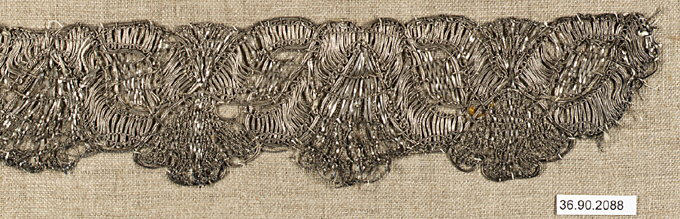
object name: piece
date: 1801-1900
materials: metal thread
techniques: lace